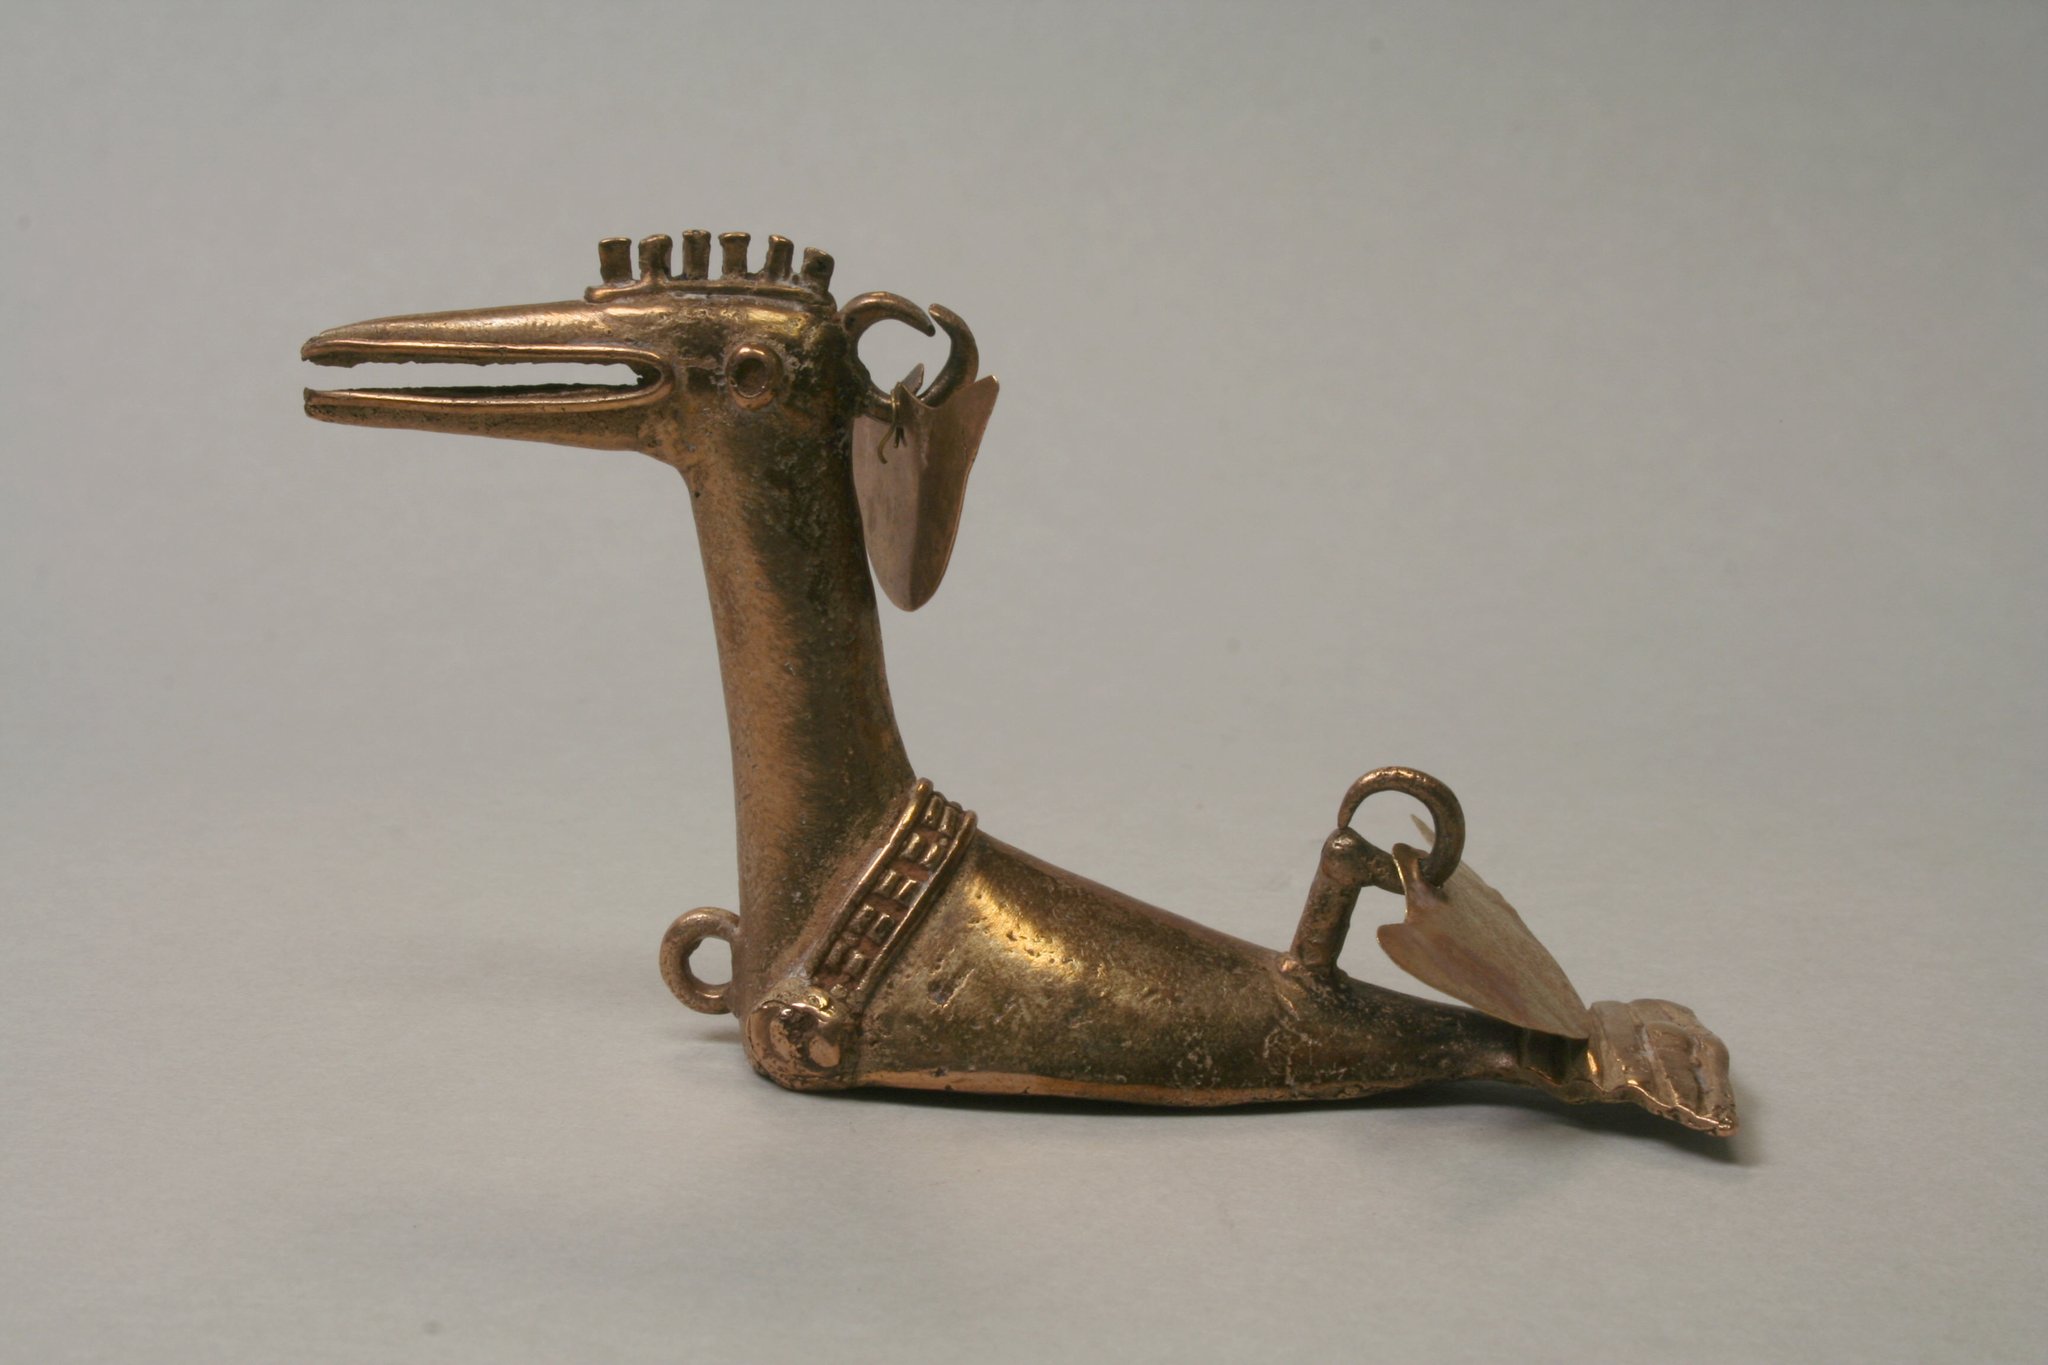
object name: pendant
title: Bird Pendant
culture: early quimbaya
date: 300 BCE-700 CE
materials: alloy, gold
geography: colombia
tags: birds